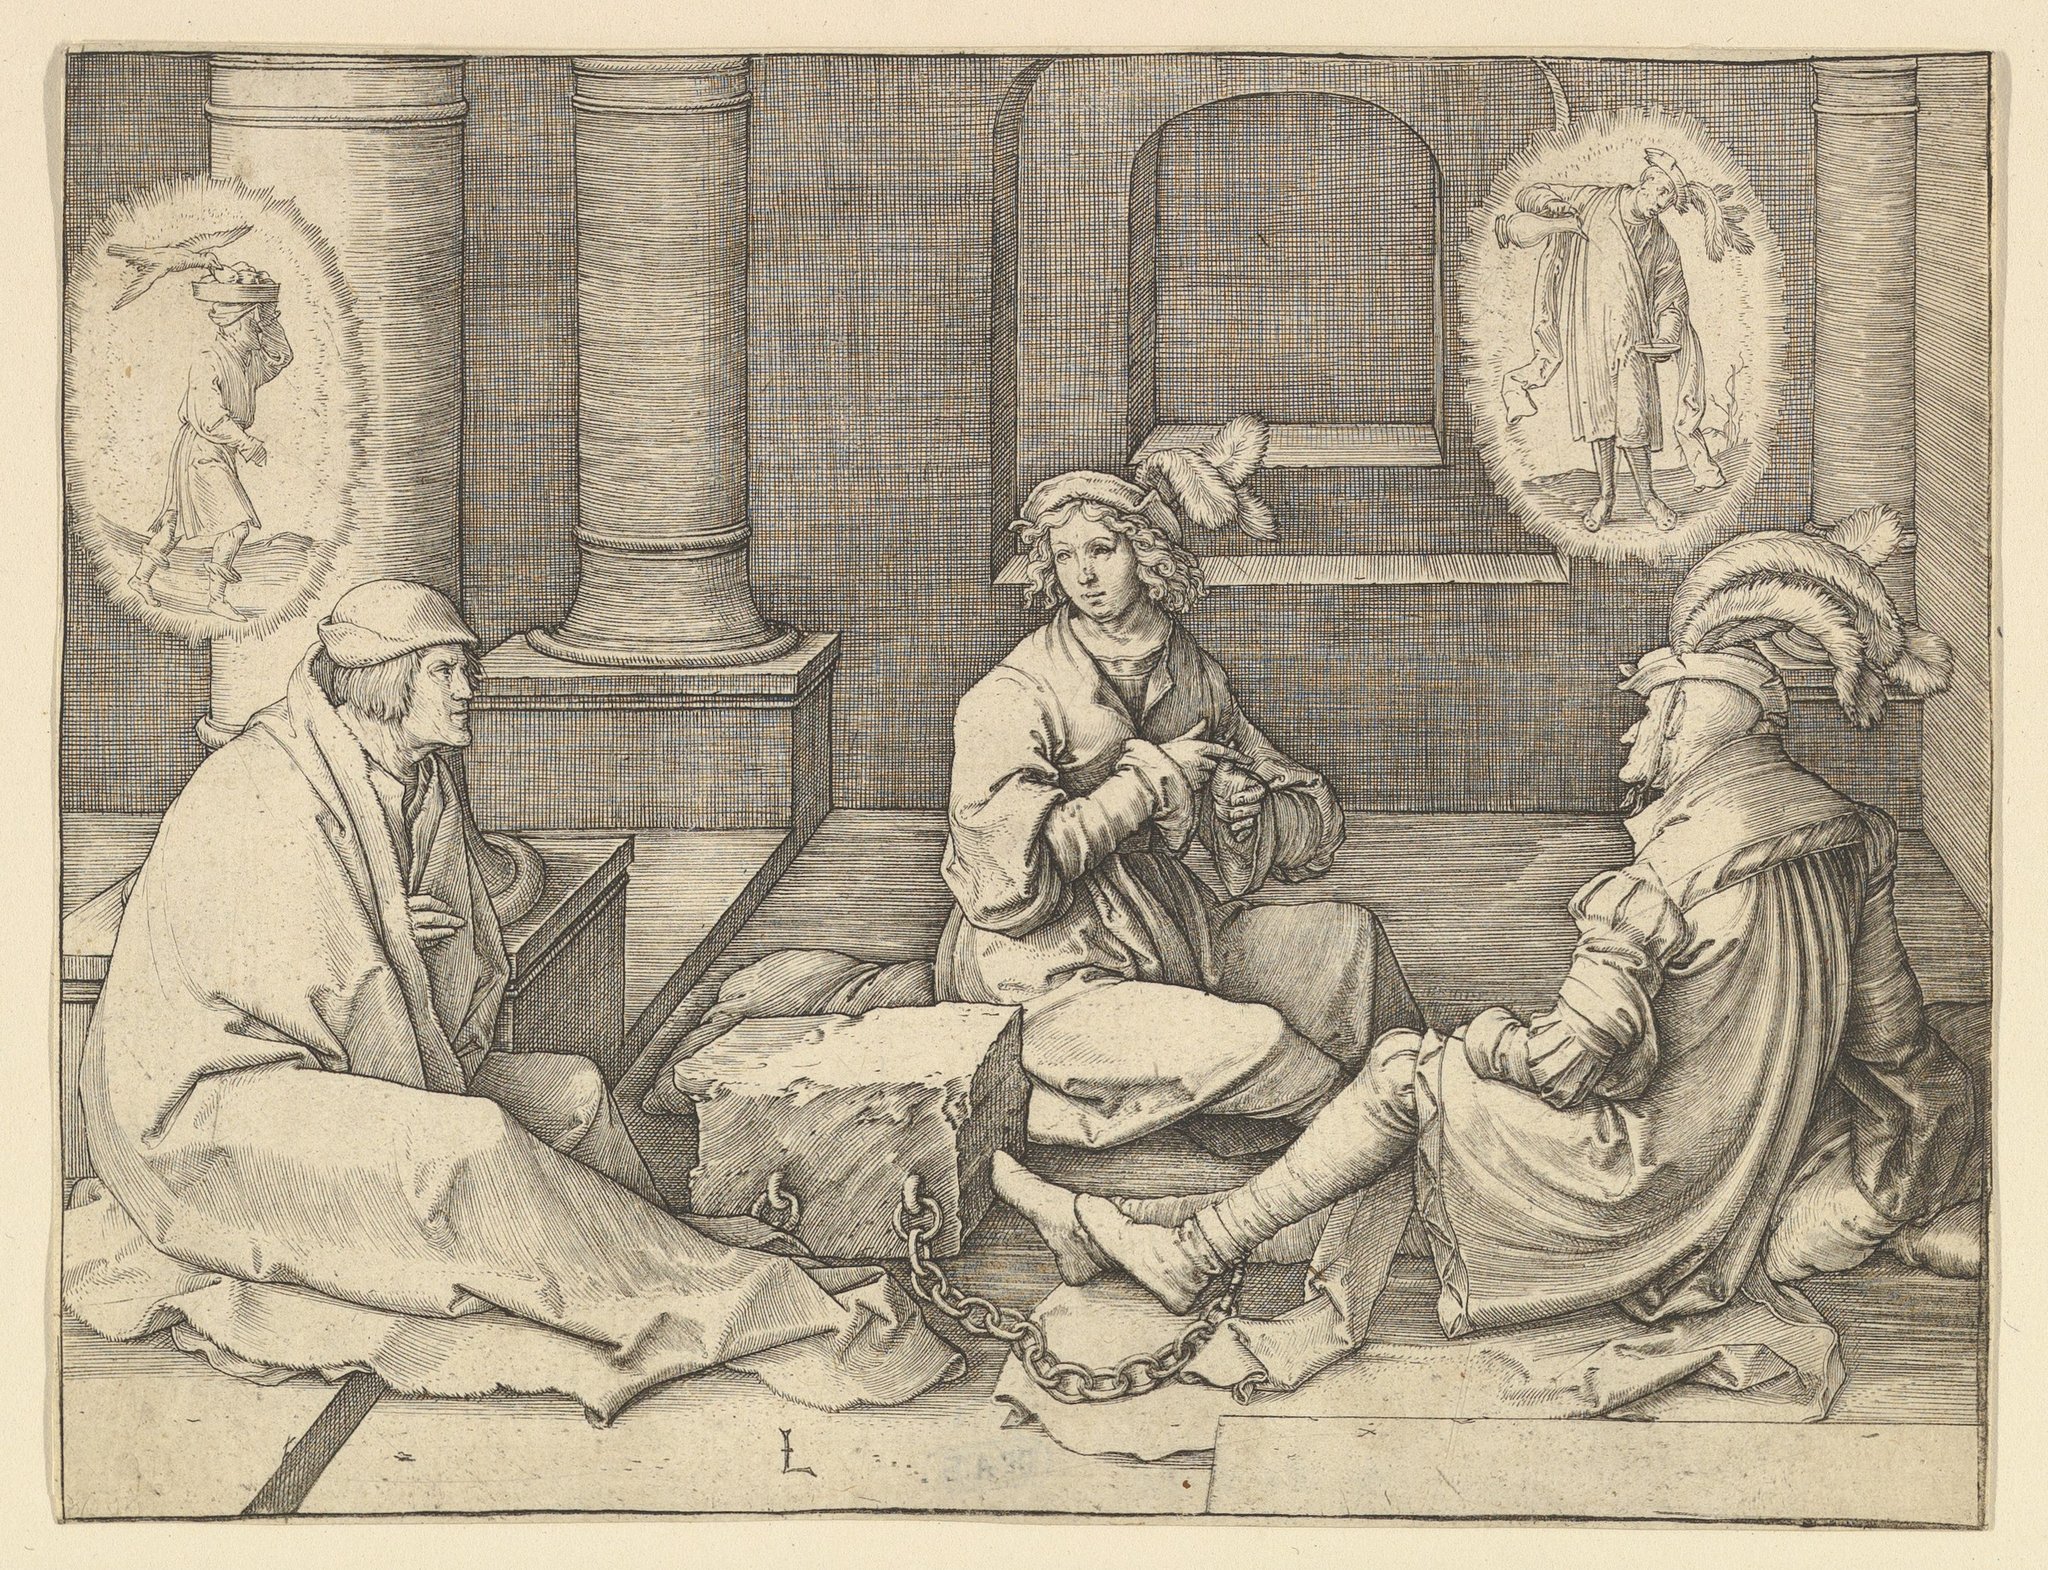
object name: print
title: Joseph Interpreting the Dreams in Prison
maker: lucas van leyden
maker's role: artist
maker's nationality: netherlandish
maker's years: 1494-1533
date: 1512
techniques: engraving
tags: prisons,prisoners,men,women